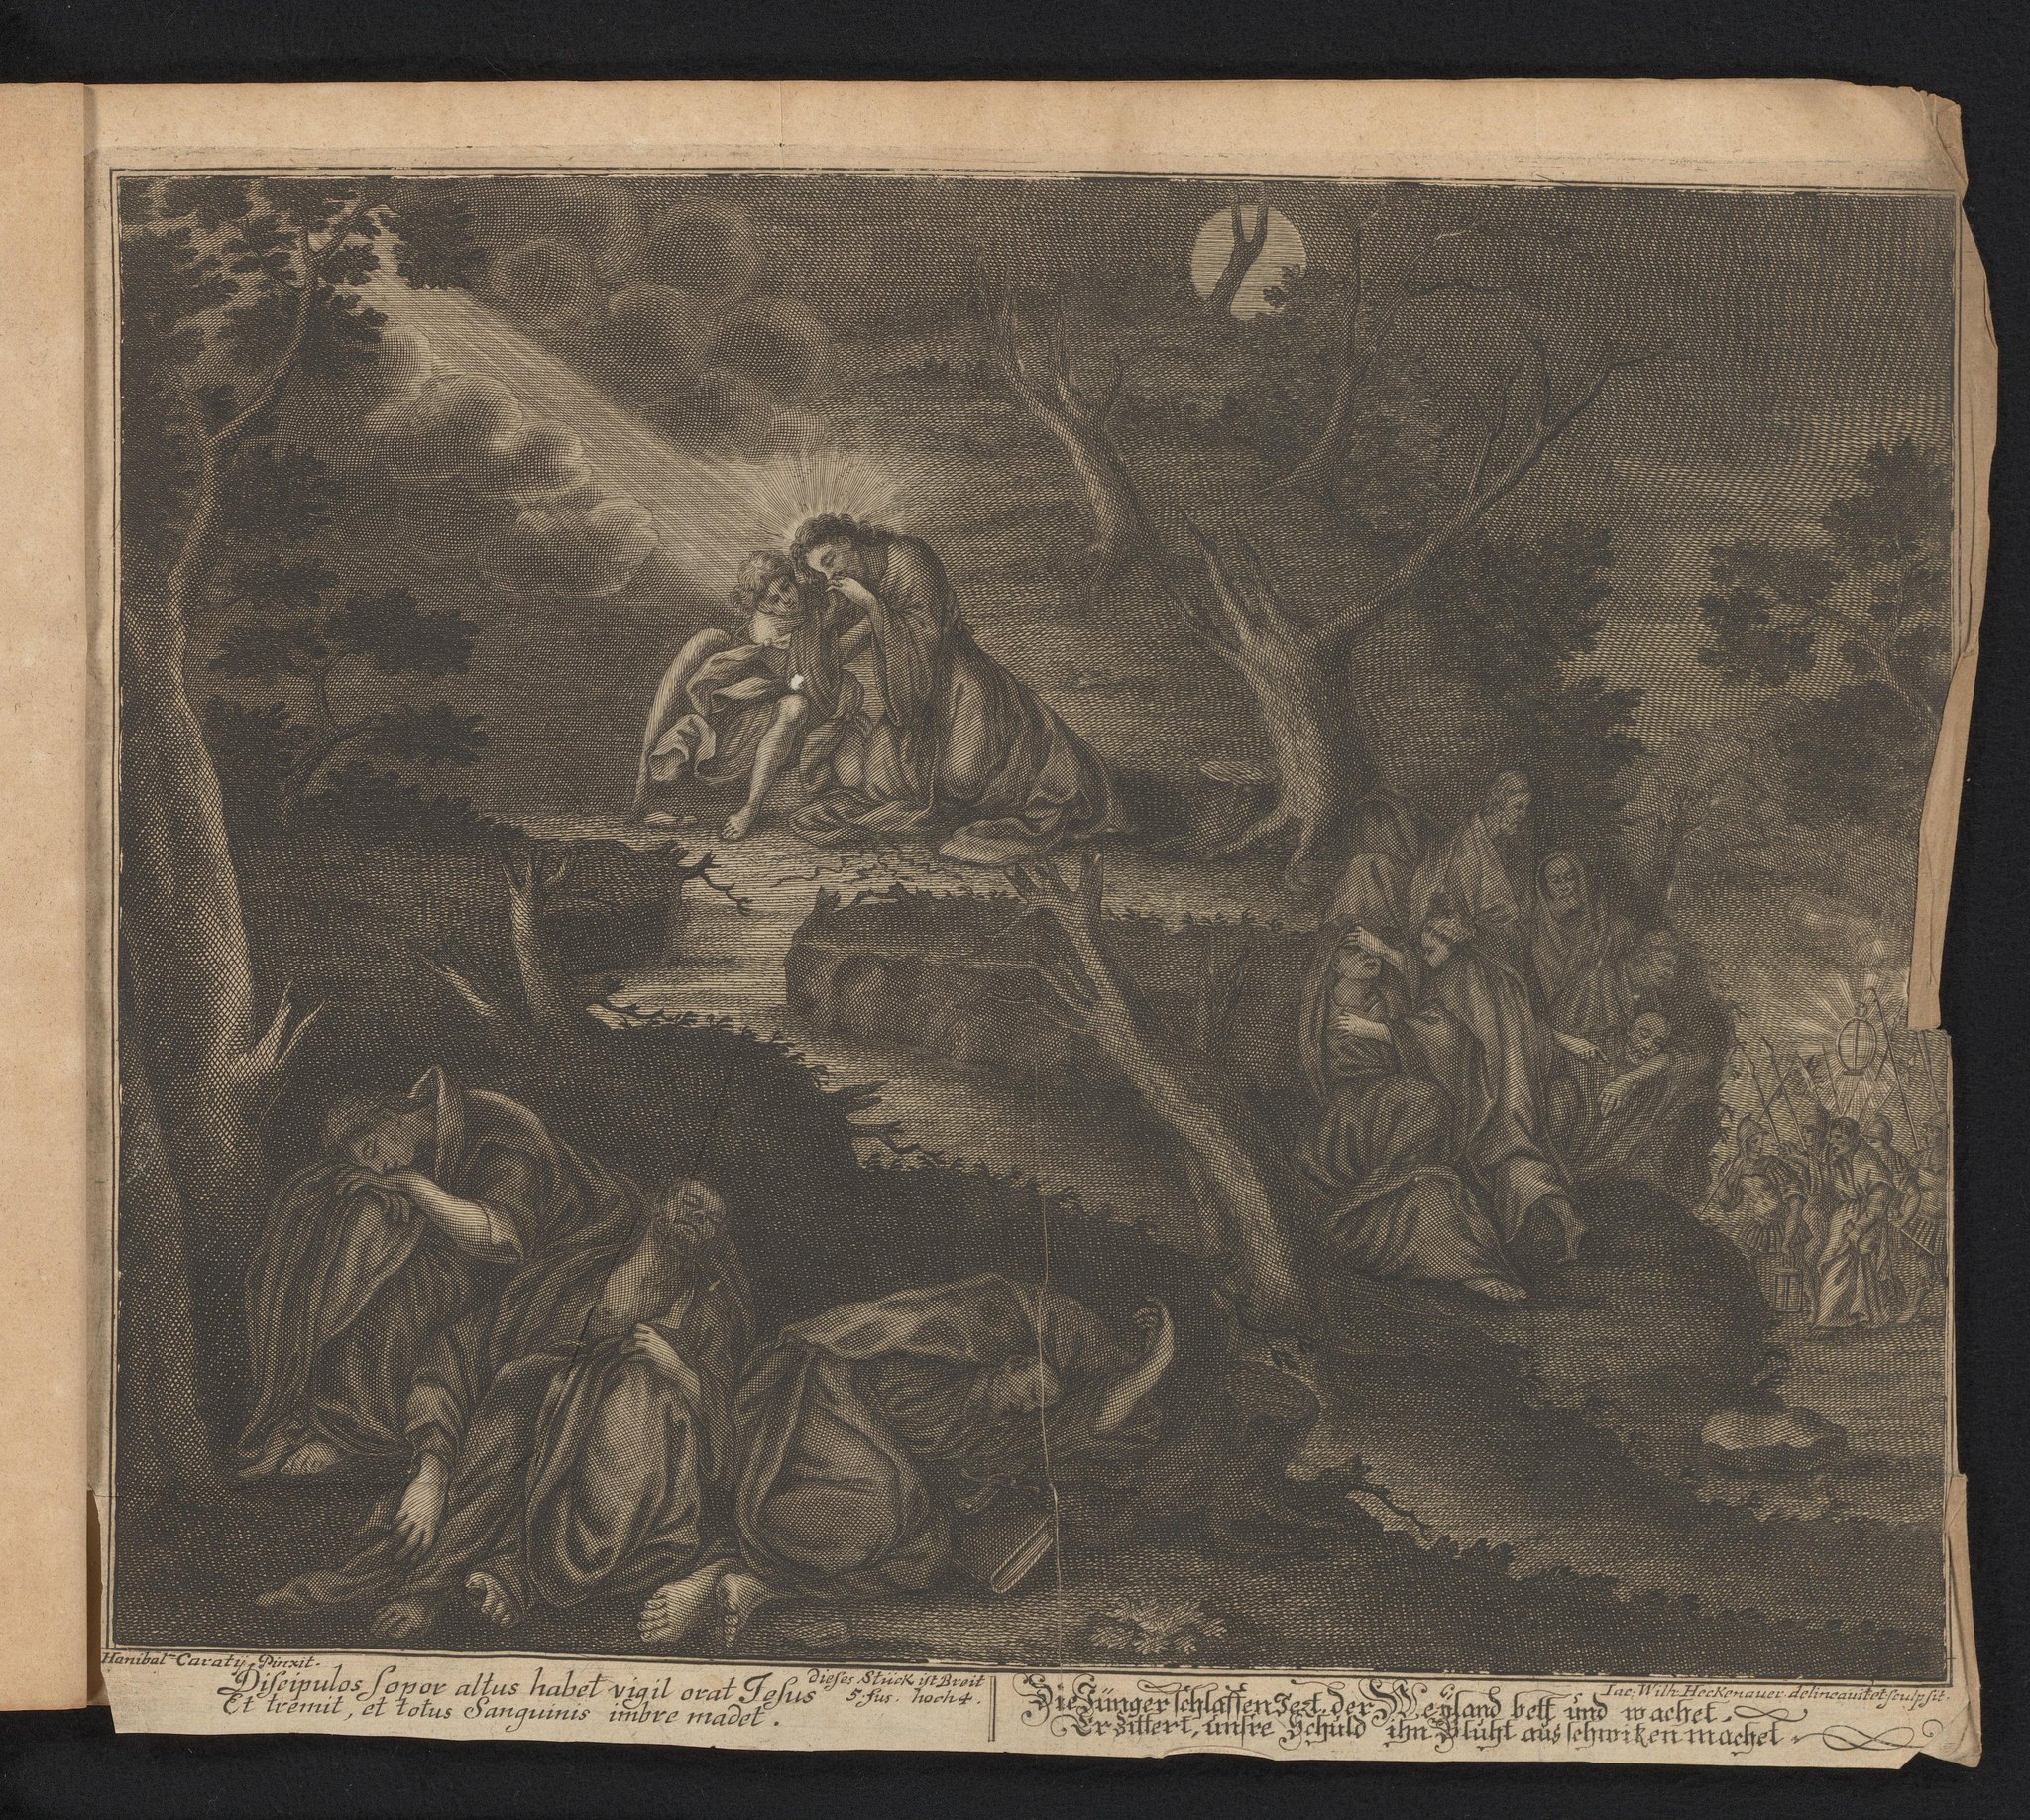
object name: print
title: Christus in de hof van Getsemane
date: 1710-1714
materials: paper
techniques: engraving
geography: wolfenbüttel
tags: agony of christ; three (or eleven) apostles sleeping, agony of christ: to comfort him one or more angels appear to christ with chalice and/or cross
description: Tekst in het Duits en het Latijn in de ondermarge. Prent maakt deel uit van een album.